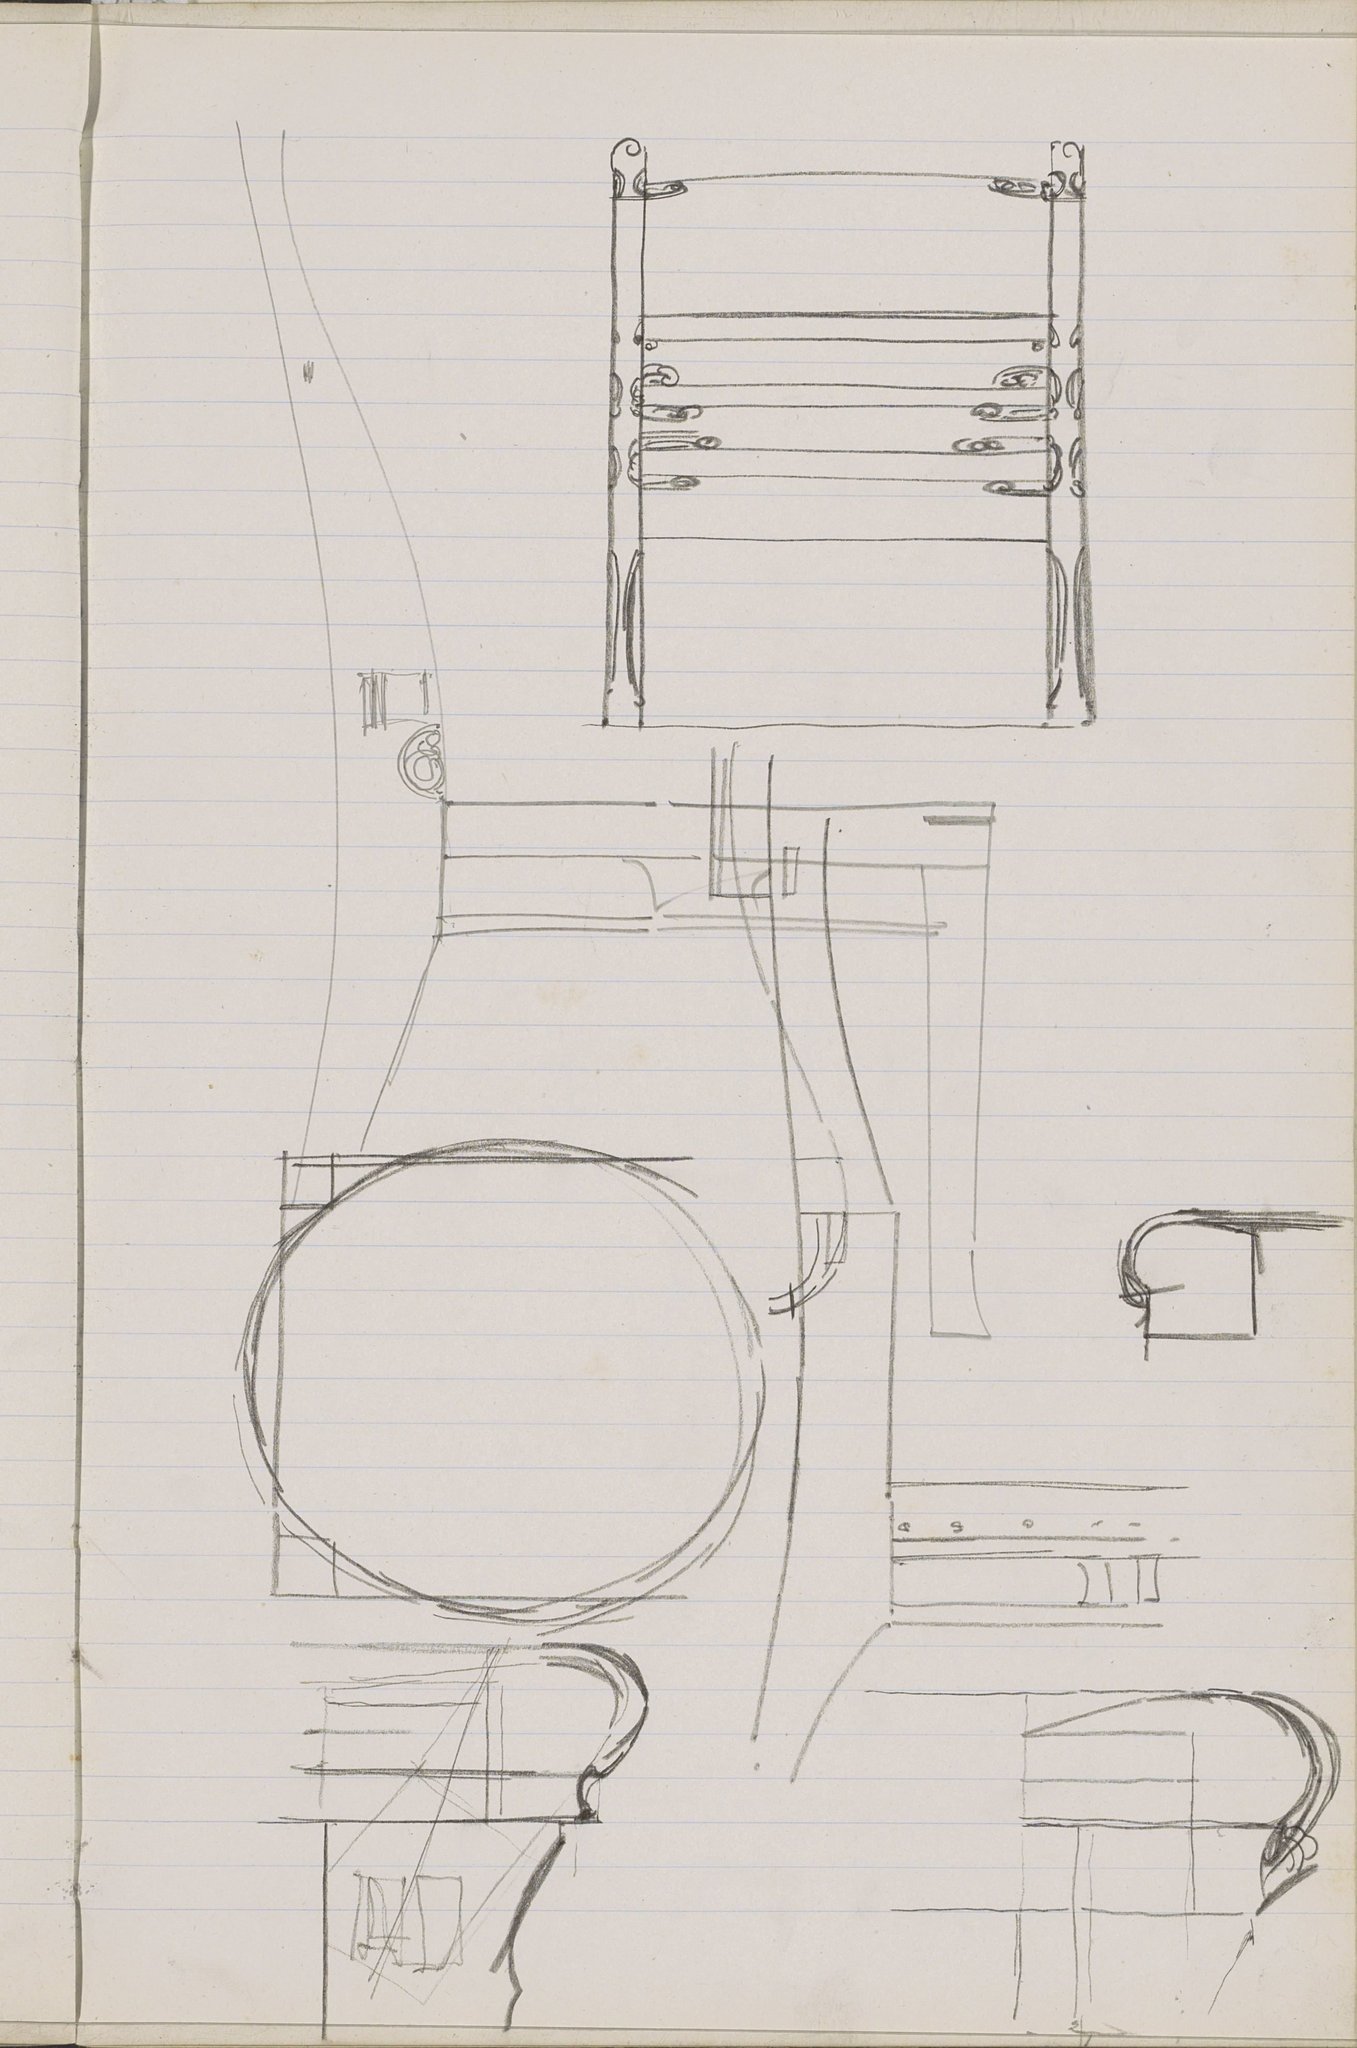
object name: sketchbook leaf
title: Meubelontwerpen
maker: gerrit willem dijsselhof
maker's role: designer, draughtsman, print maker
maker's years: 1866-1924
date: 1901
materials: chalk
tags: furniture and household effects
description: Blad 23 recto uit een schetsboek met 79 bladen.